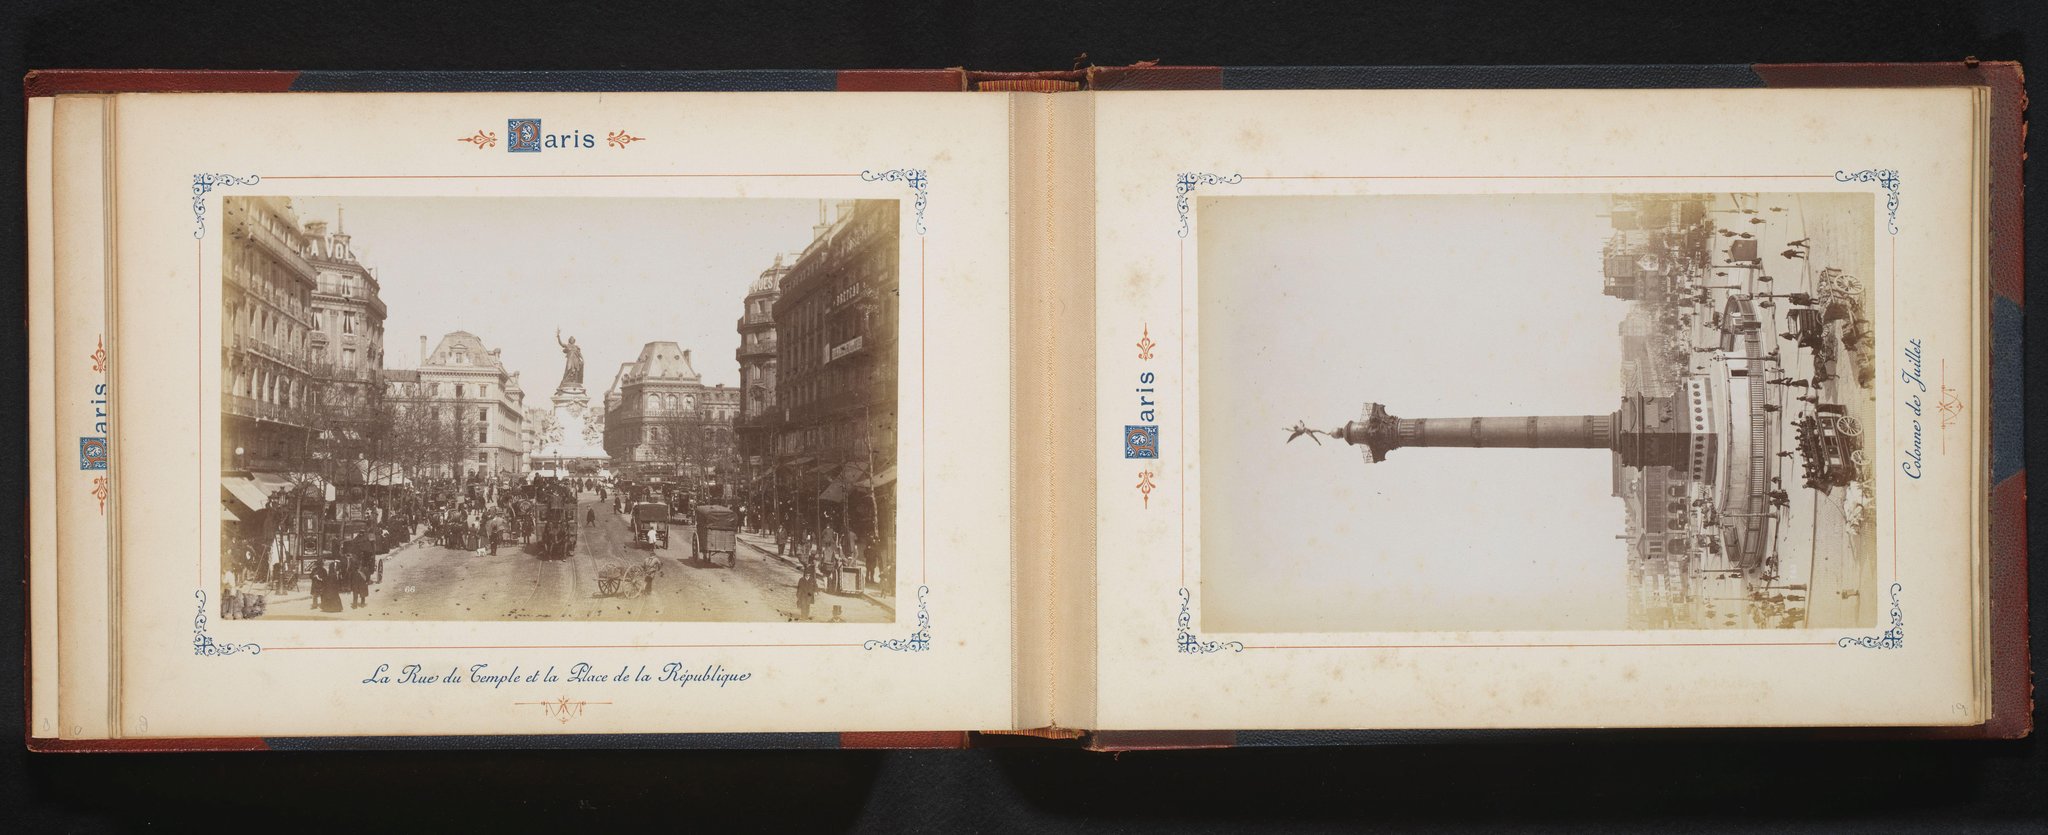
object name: photograph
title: Place de la République te Parijs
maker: Anonymous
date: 1879-1889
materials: photographic support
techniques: albumen print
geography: rue du temple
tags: square, place, circus, etc., sculpture, street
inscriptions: number: ‘66’